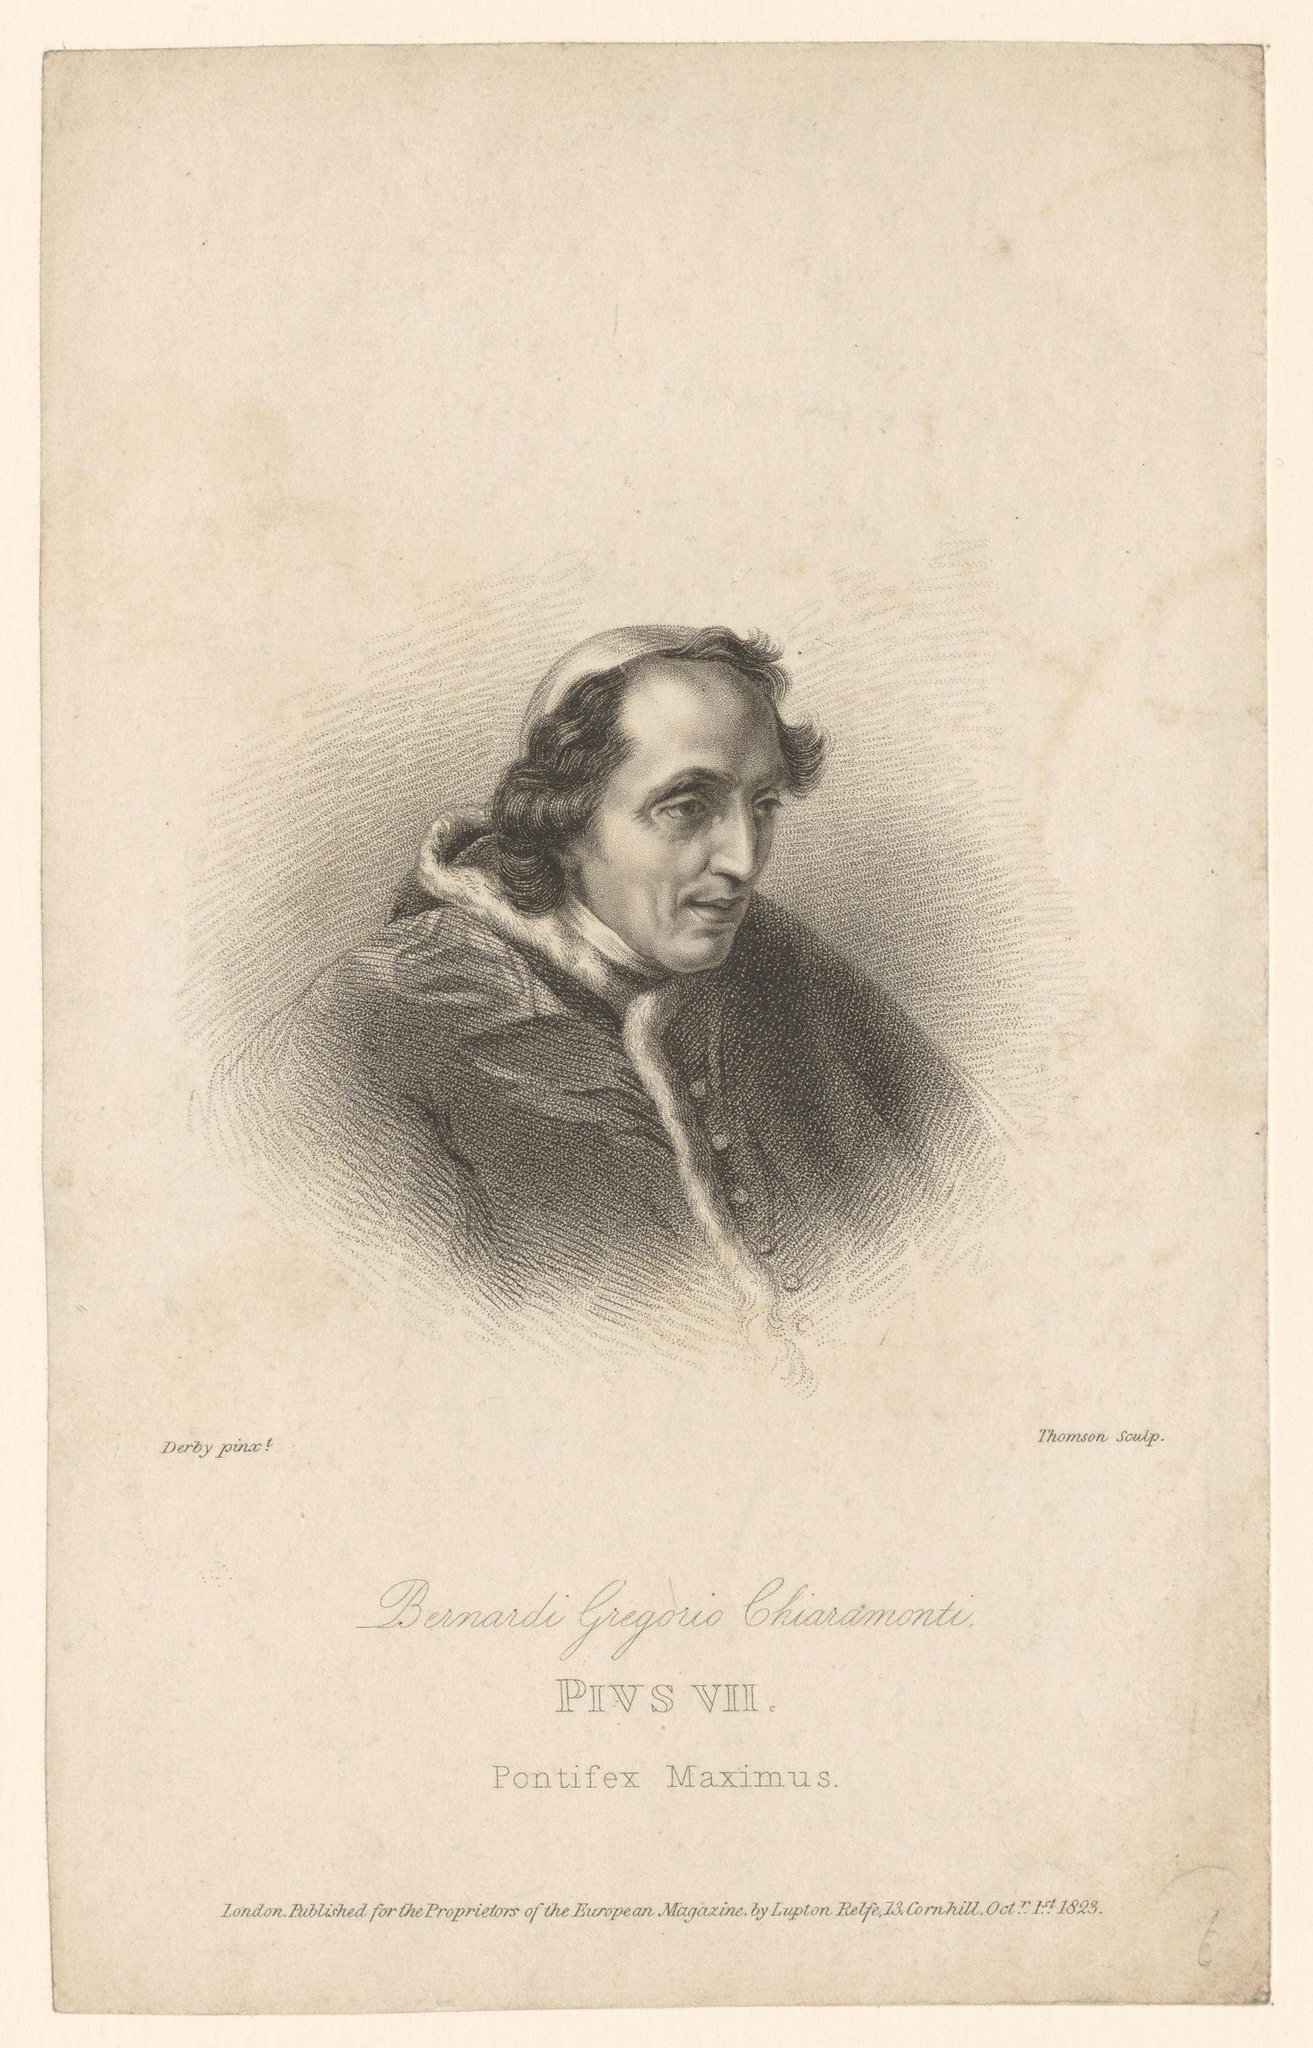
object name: print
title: Portret van Pius VII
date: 1810-1823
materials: paper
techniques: engraving, roulette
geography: london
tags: rome, pius vii, historical persons, pope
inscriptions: collector's mark: Lugt 2228